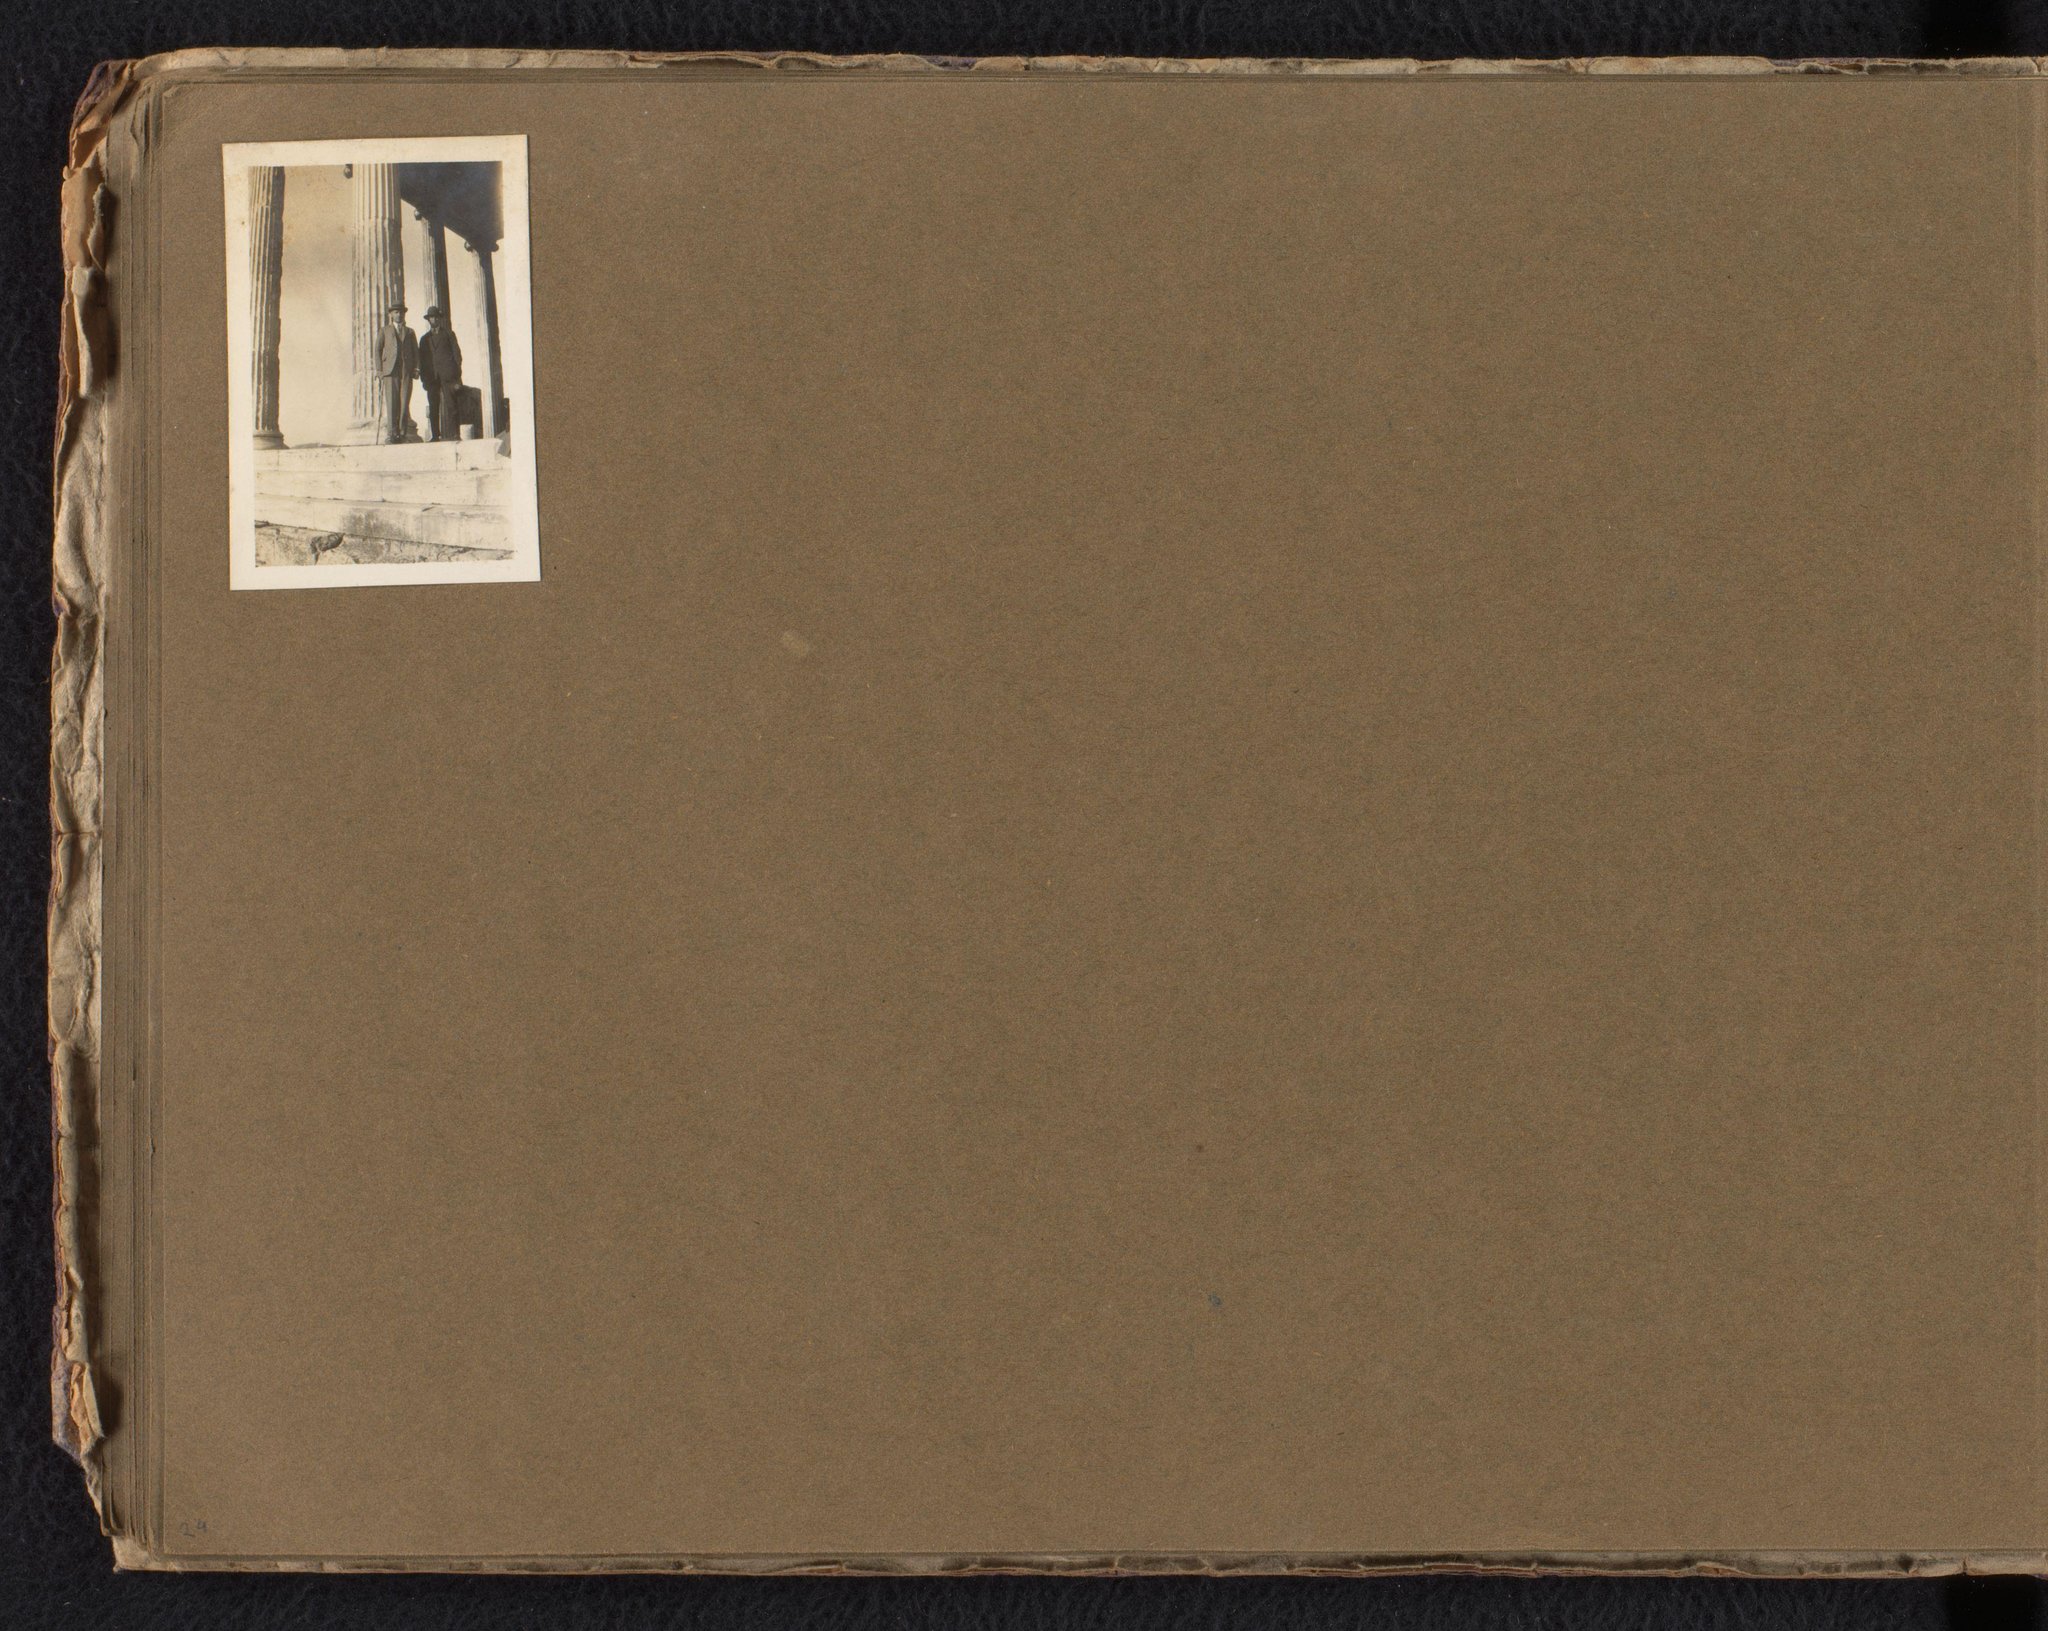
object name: photograph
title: Frank Willem Tobias Furnée en een andere man bij een Griekse tempel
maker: carolina frederika onnen (lien/loen)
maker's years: 1896-1983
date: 1926-1927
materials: paper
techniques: gelatin silver print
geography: greece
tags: the hague, historical persons, temple, shrine ~ greek religion